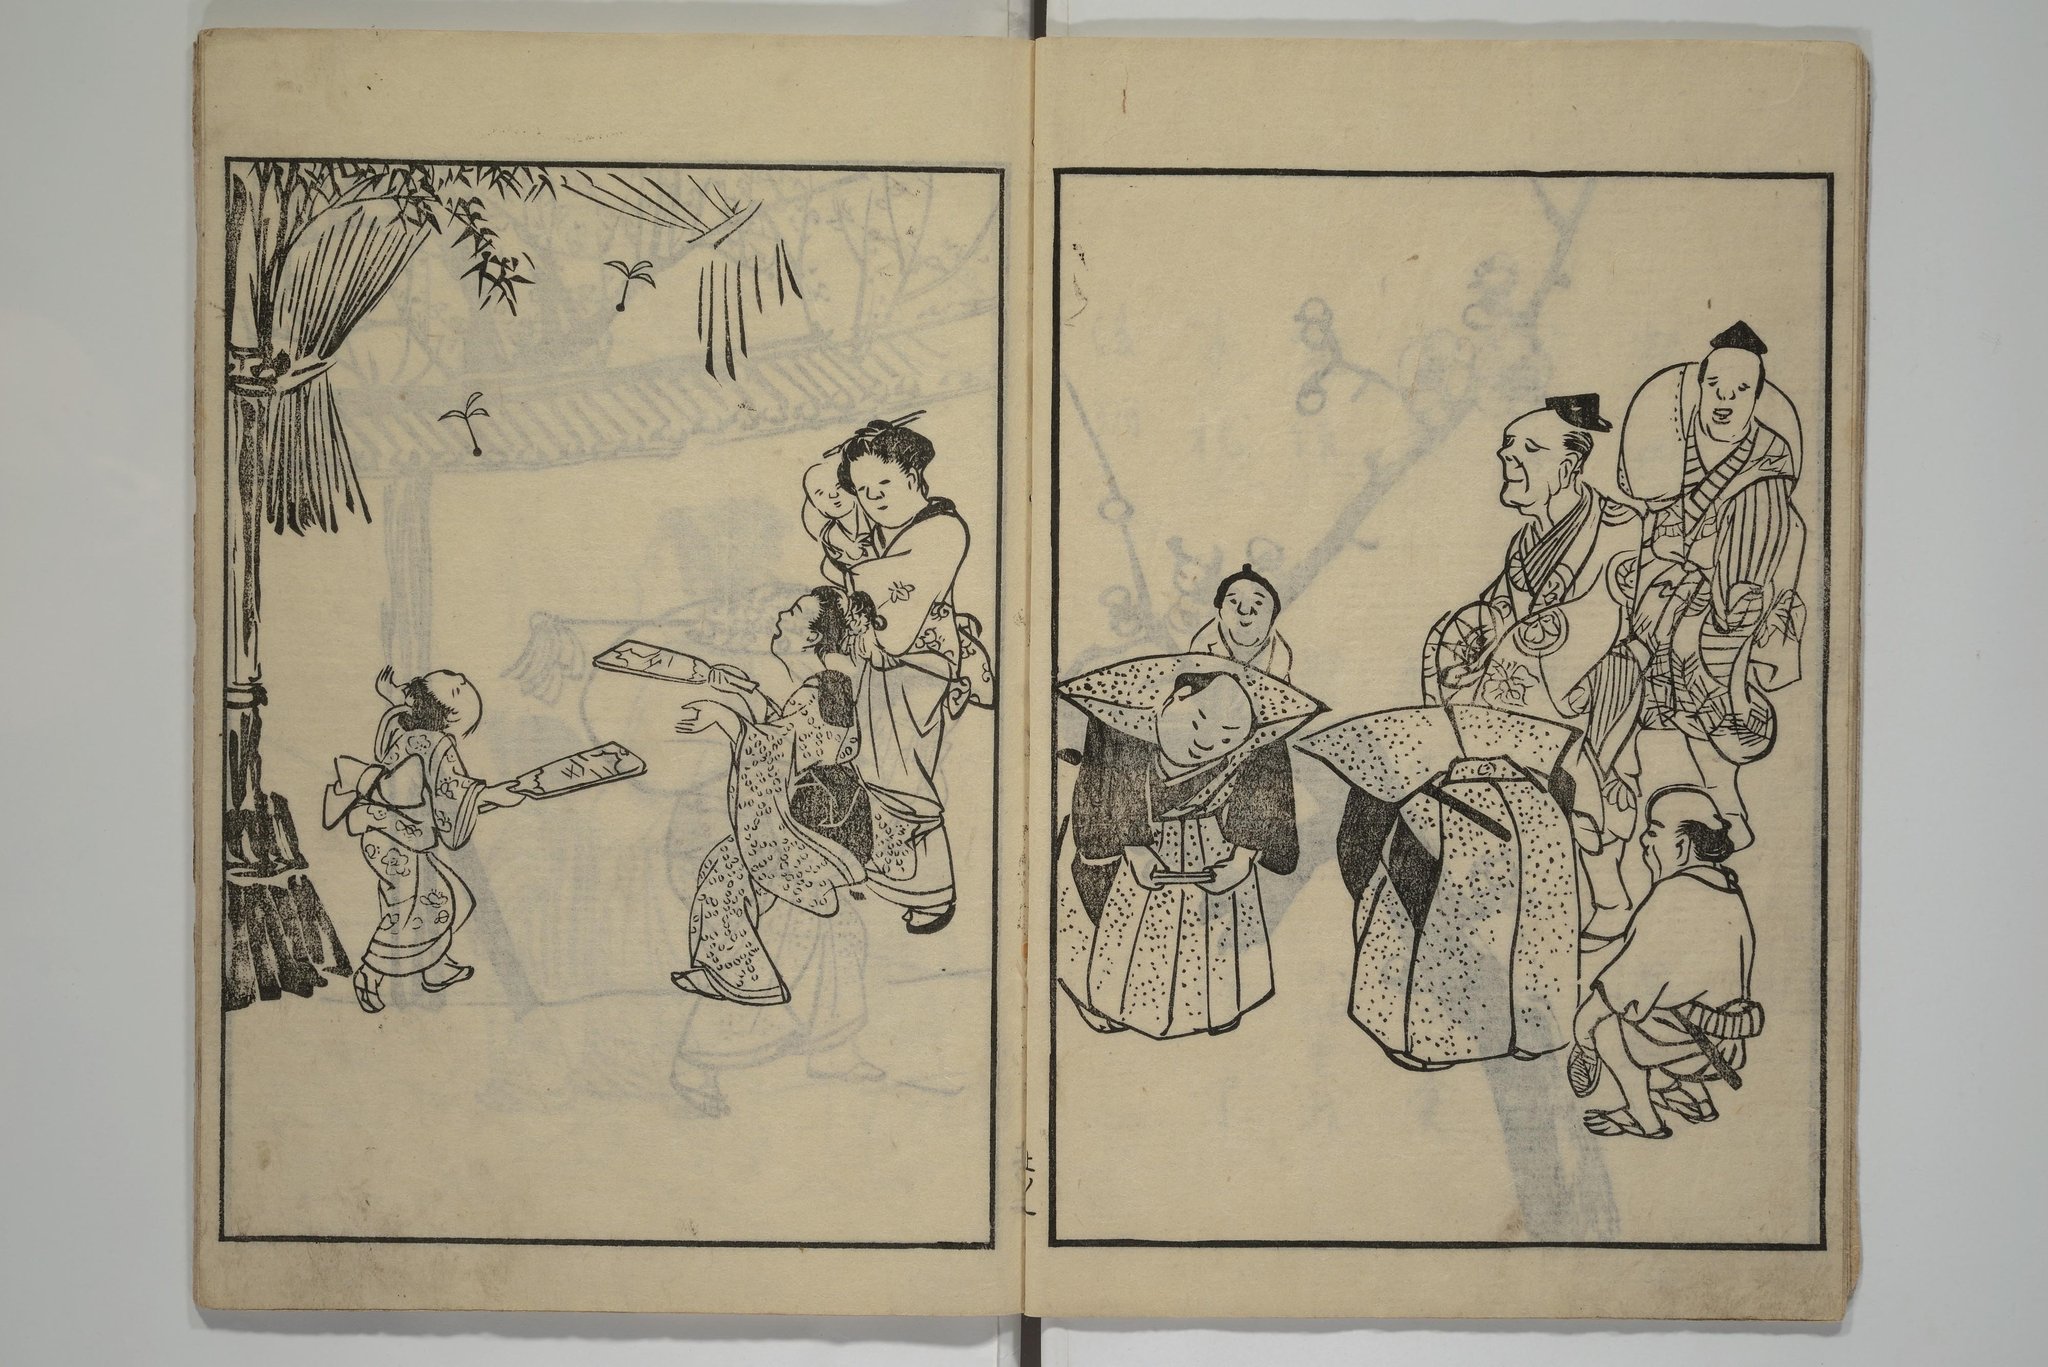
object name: illustrated book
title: People of Yamato (Japan) Picture Album (Yamato jinbutsu gafu) 倭人物画譜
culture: japanese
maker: yamaguchi soken 山口素絢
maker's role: artist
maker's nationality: japanese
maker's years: 1759-1818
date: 1800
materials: ink, paper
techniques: woodblock print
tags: men,women